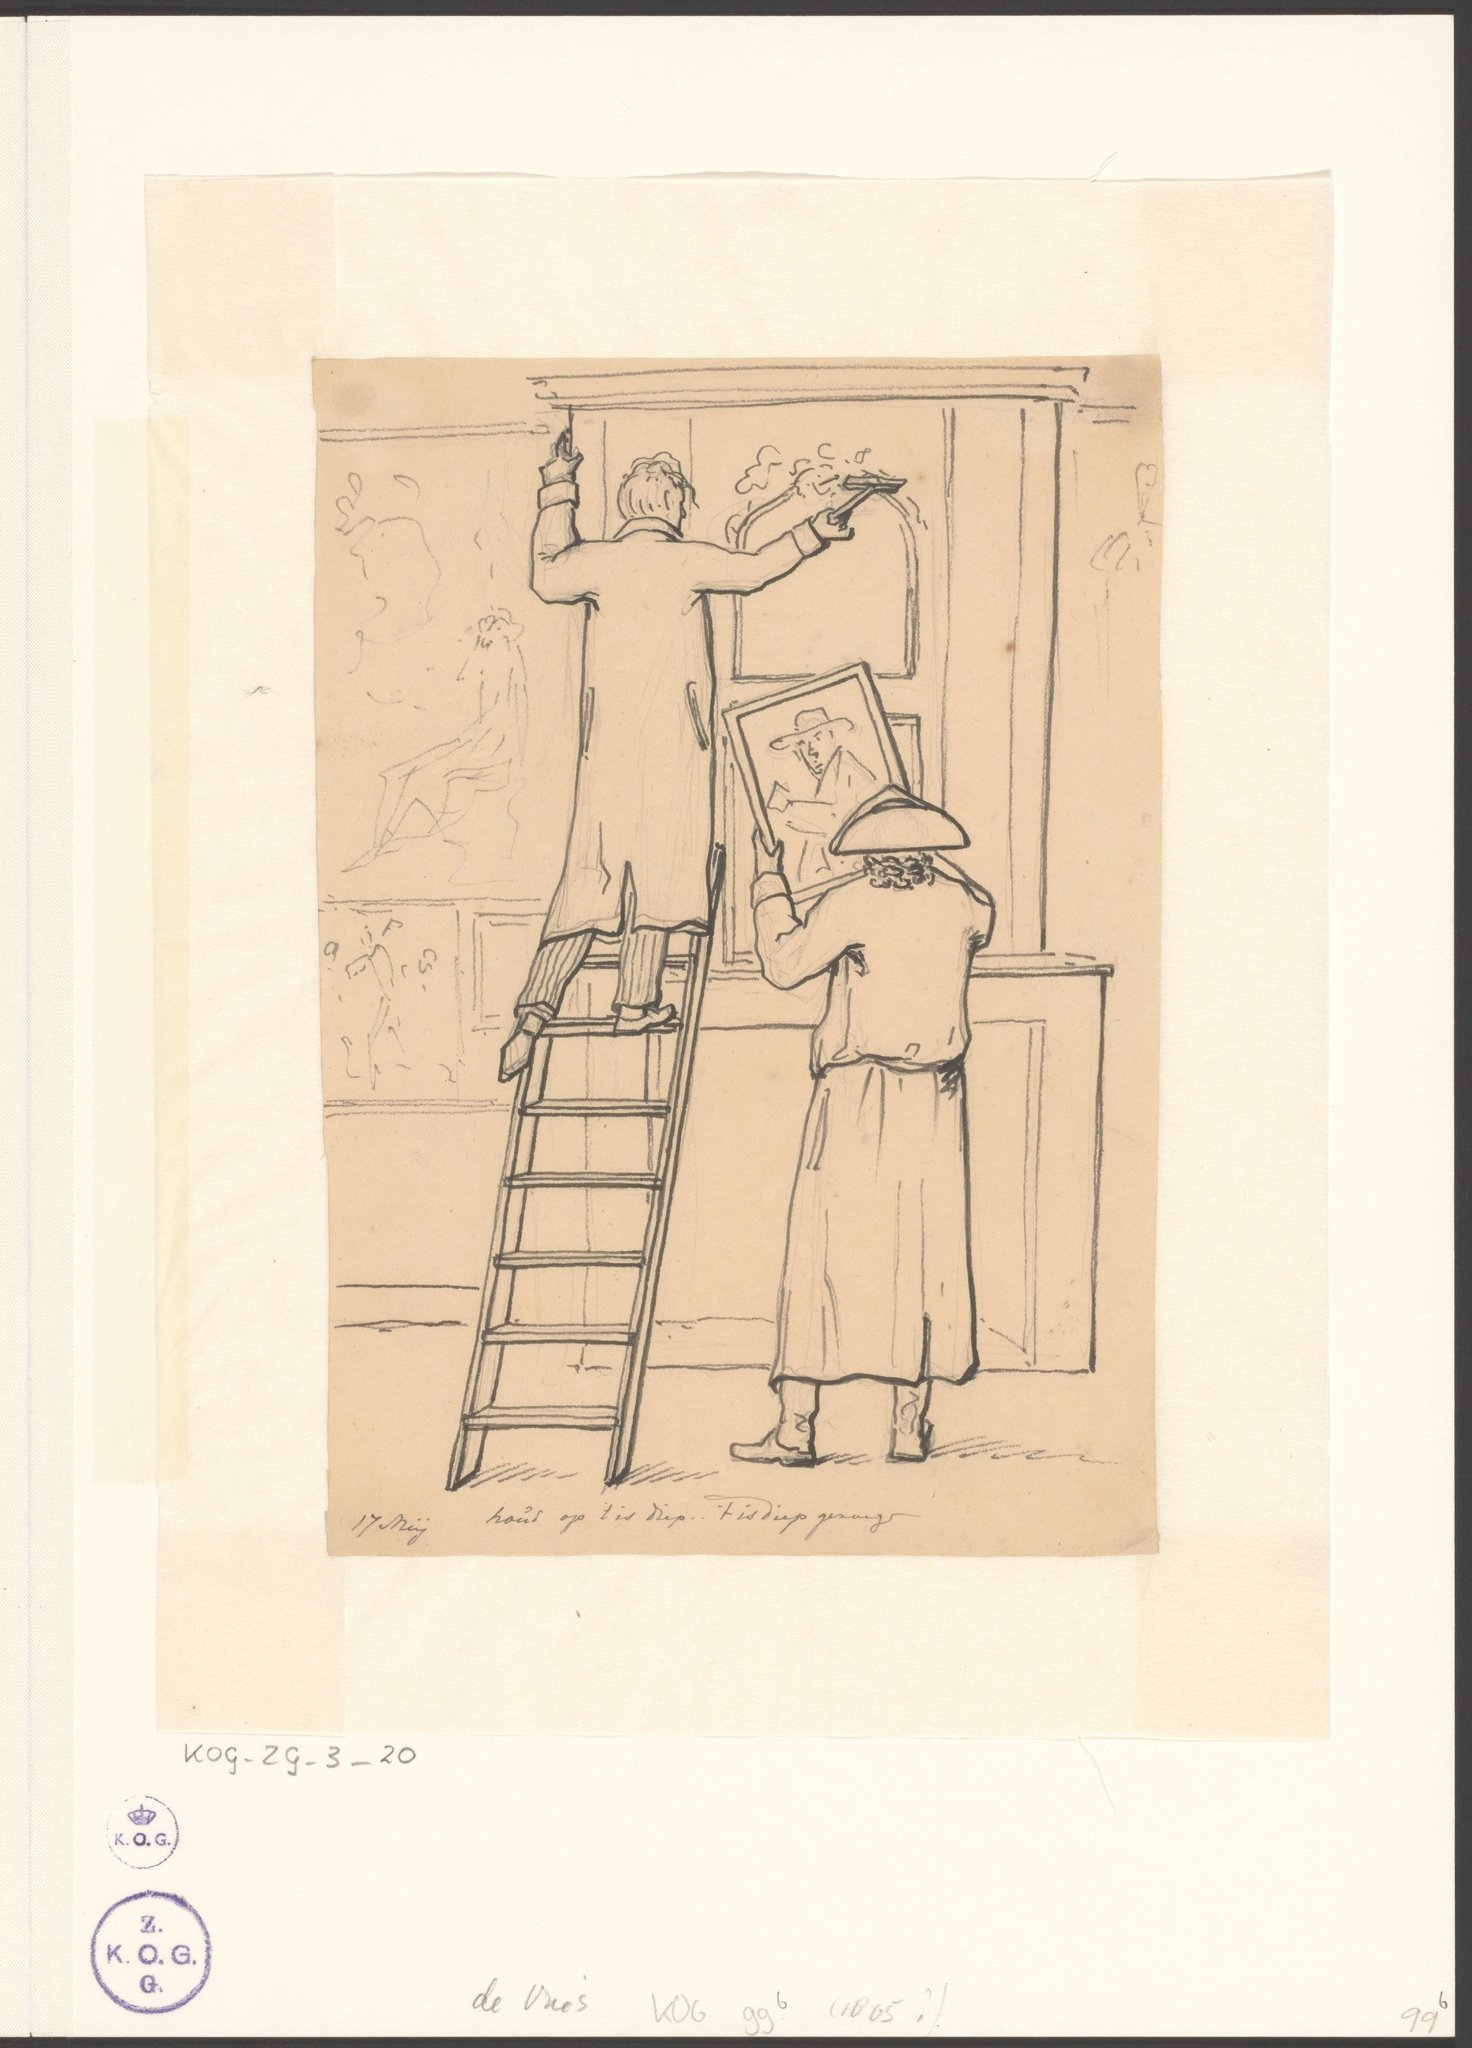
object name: drawing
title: Christiaan Andriessen hangt een schilderij op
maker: christiaan andriessen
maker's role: draughtsman, print maker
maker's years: 1775-1846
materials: ink, paper, pencil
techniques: pen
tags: picture, painting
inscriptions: inscription: ‘17 Maij [....] op 't is diep.. 't is diep genoeg’, inscription: ‘J Andriessen’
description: Dagboekblad uit het getekende dagboek dat Christiaan Andriessen bijhield van 1805 tot en met 1808.